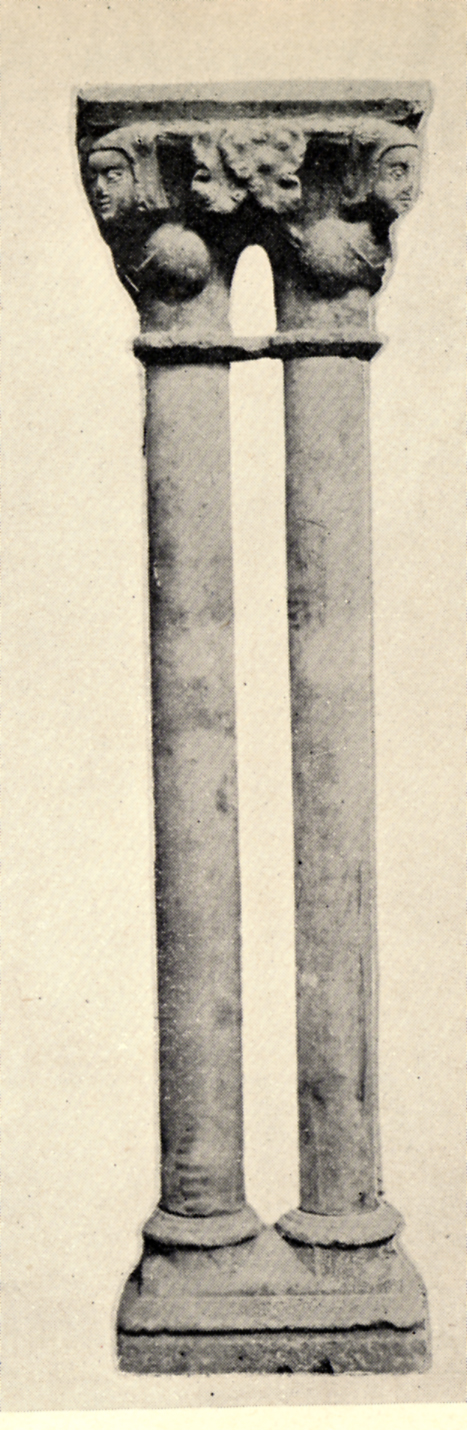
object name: base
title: Double Column Base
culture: french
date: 1201-1400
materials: limestone, stone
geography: france